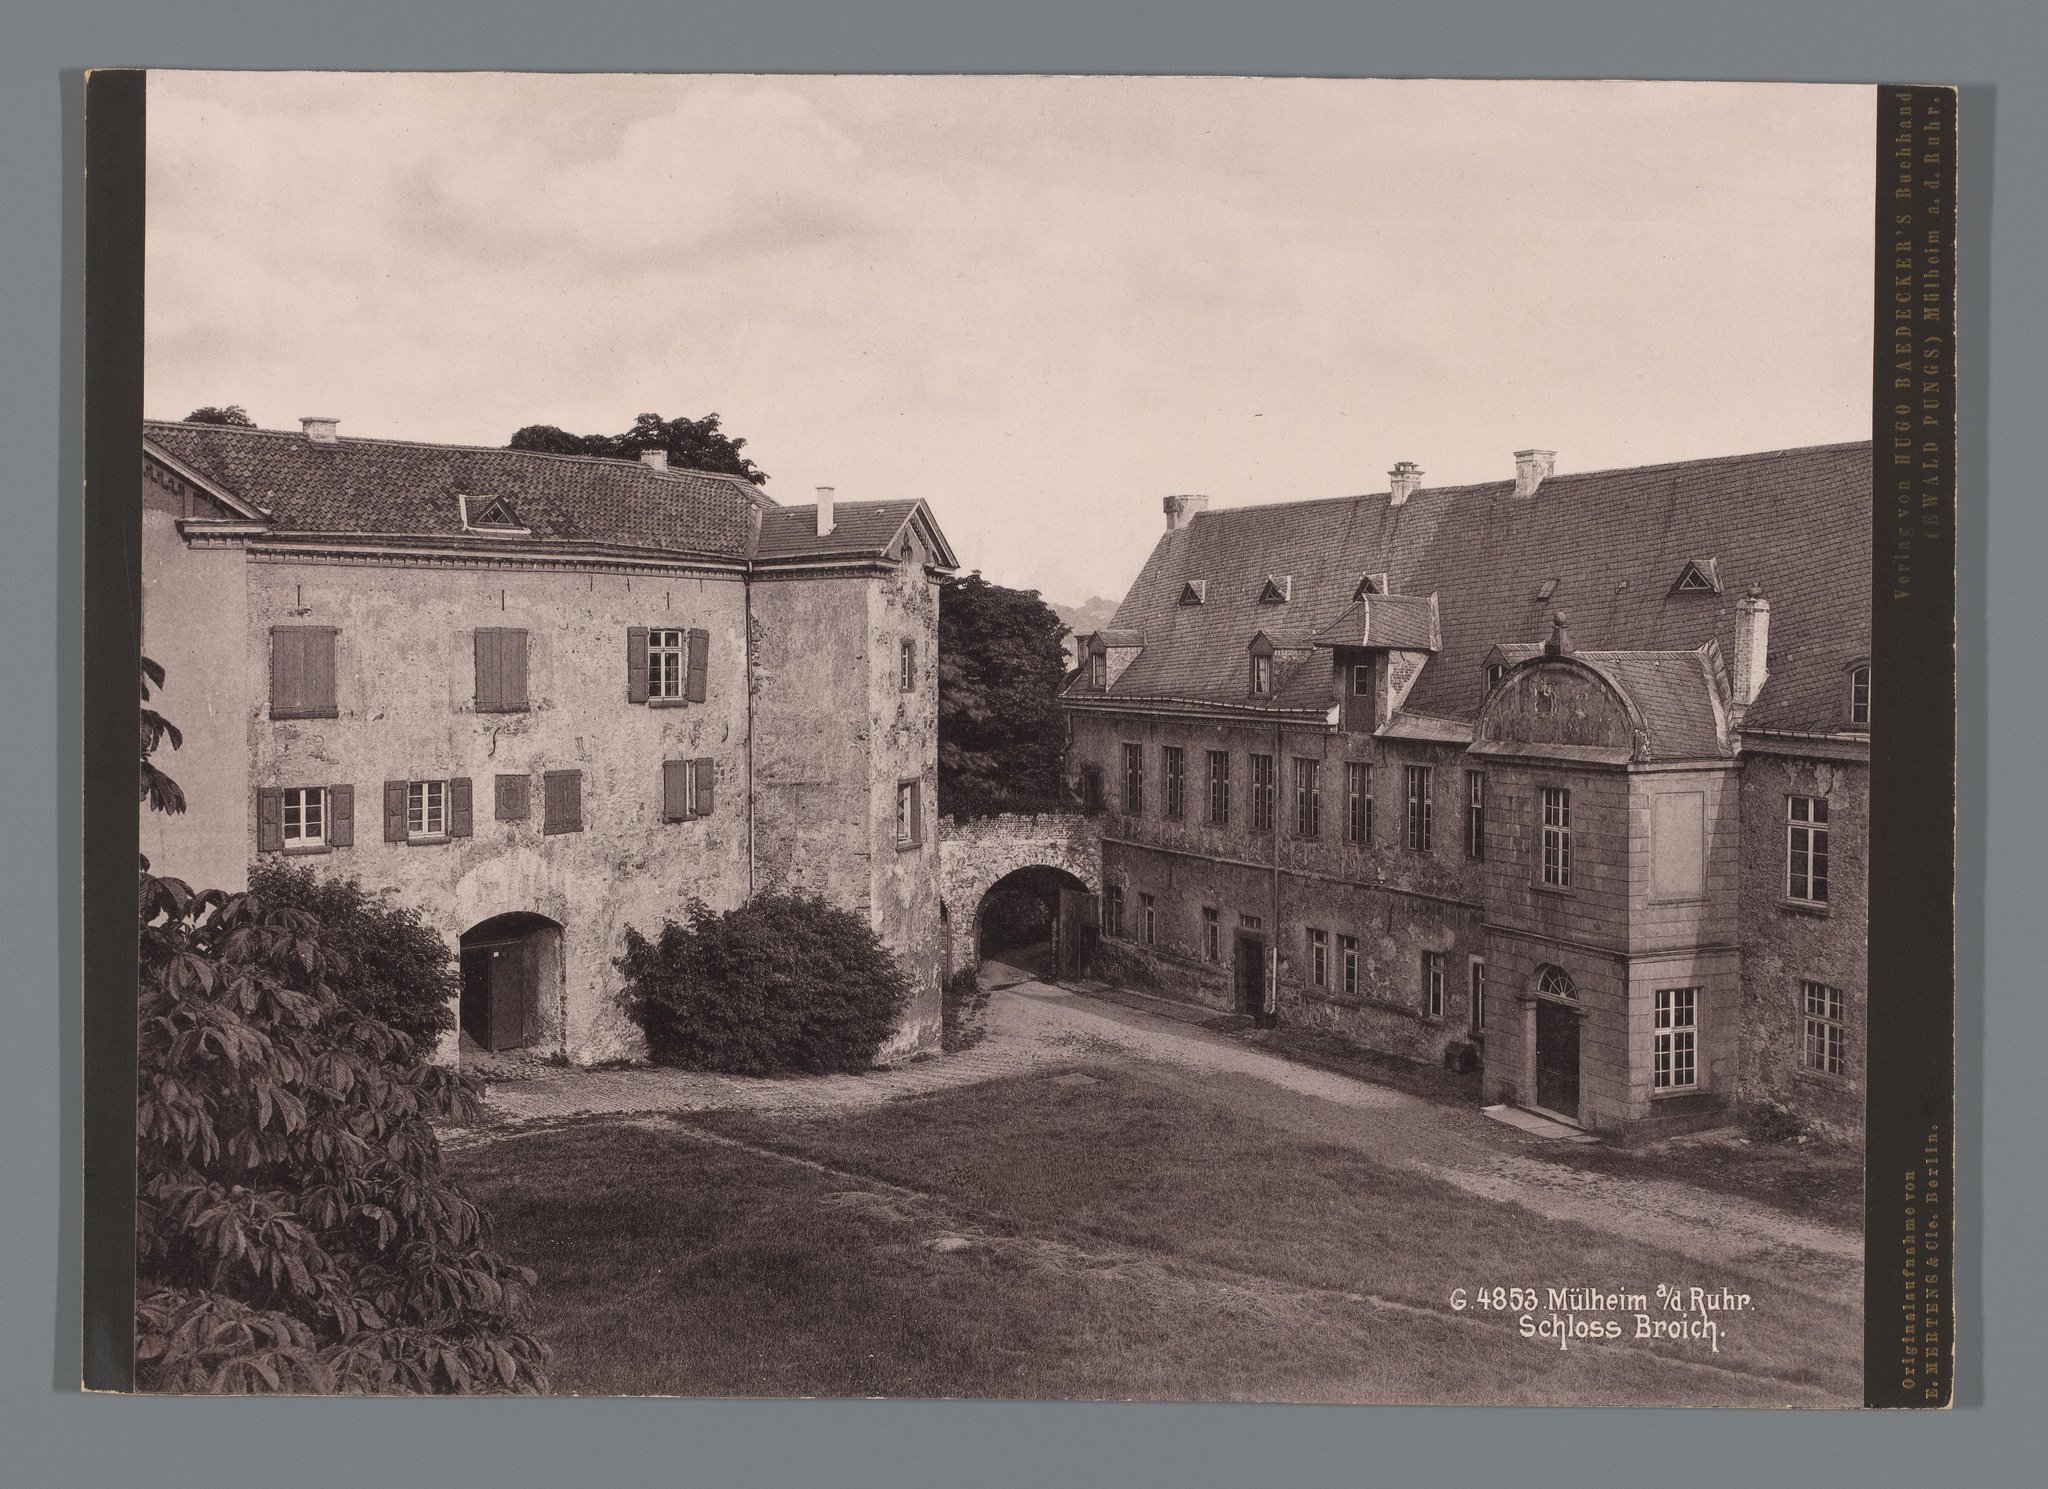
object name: photograph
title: Schloss Broich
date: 1880-1920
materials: cardboard, paper, photographic support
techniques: photograph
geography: berlin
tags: mülheim an der ruhr